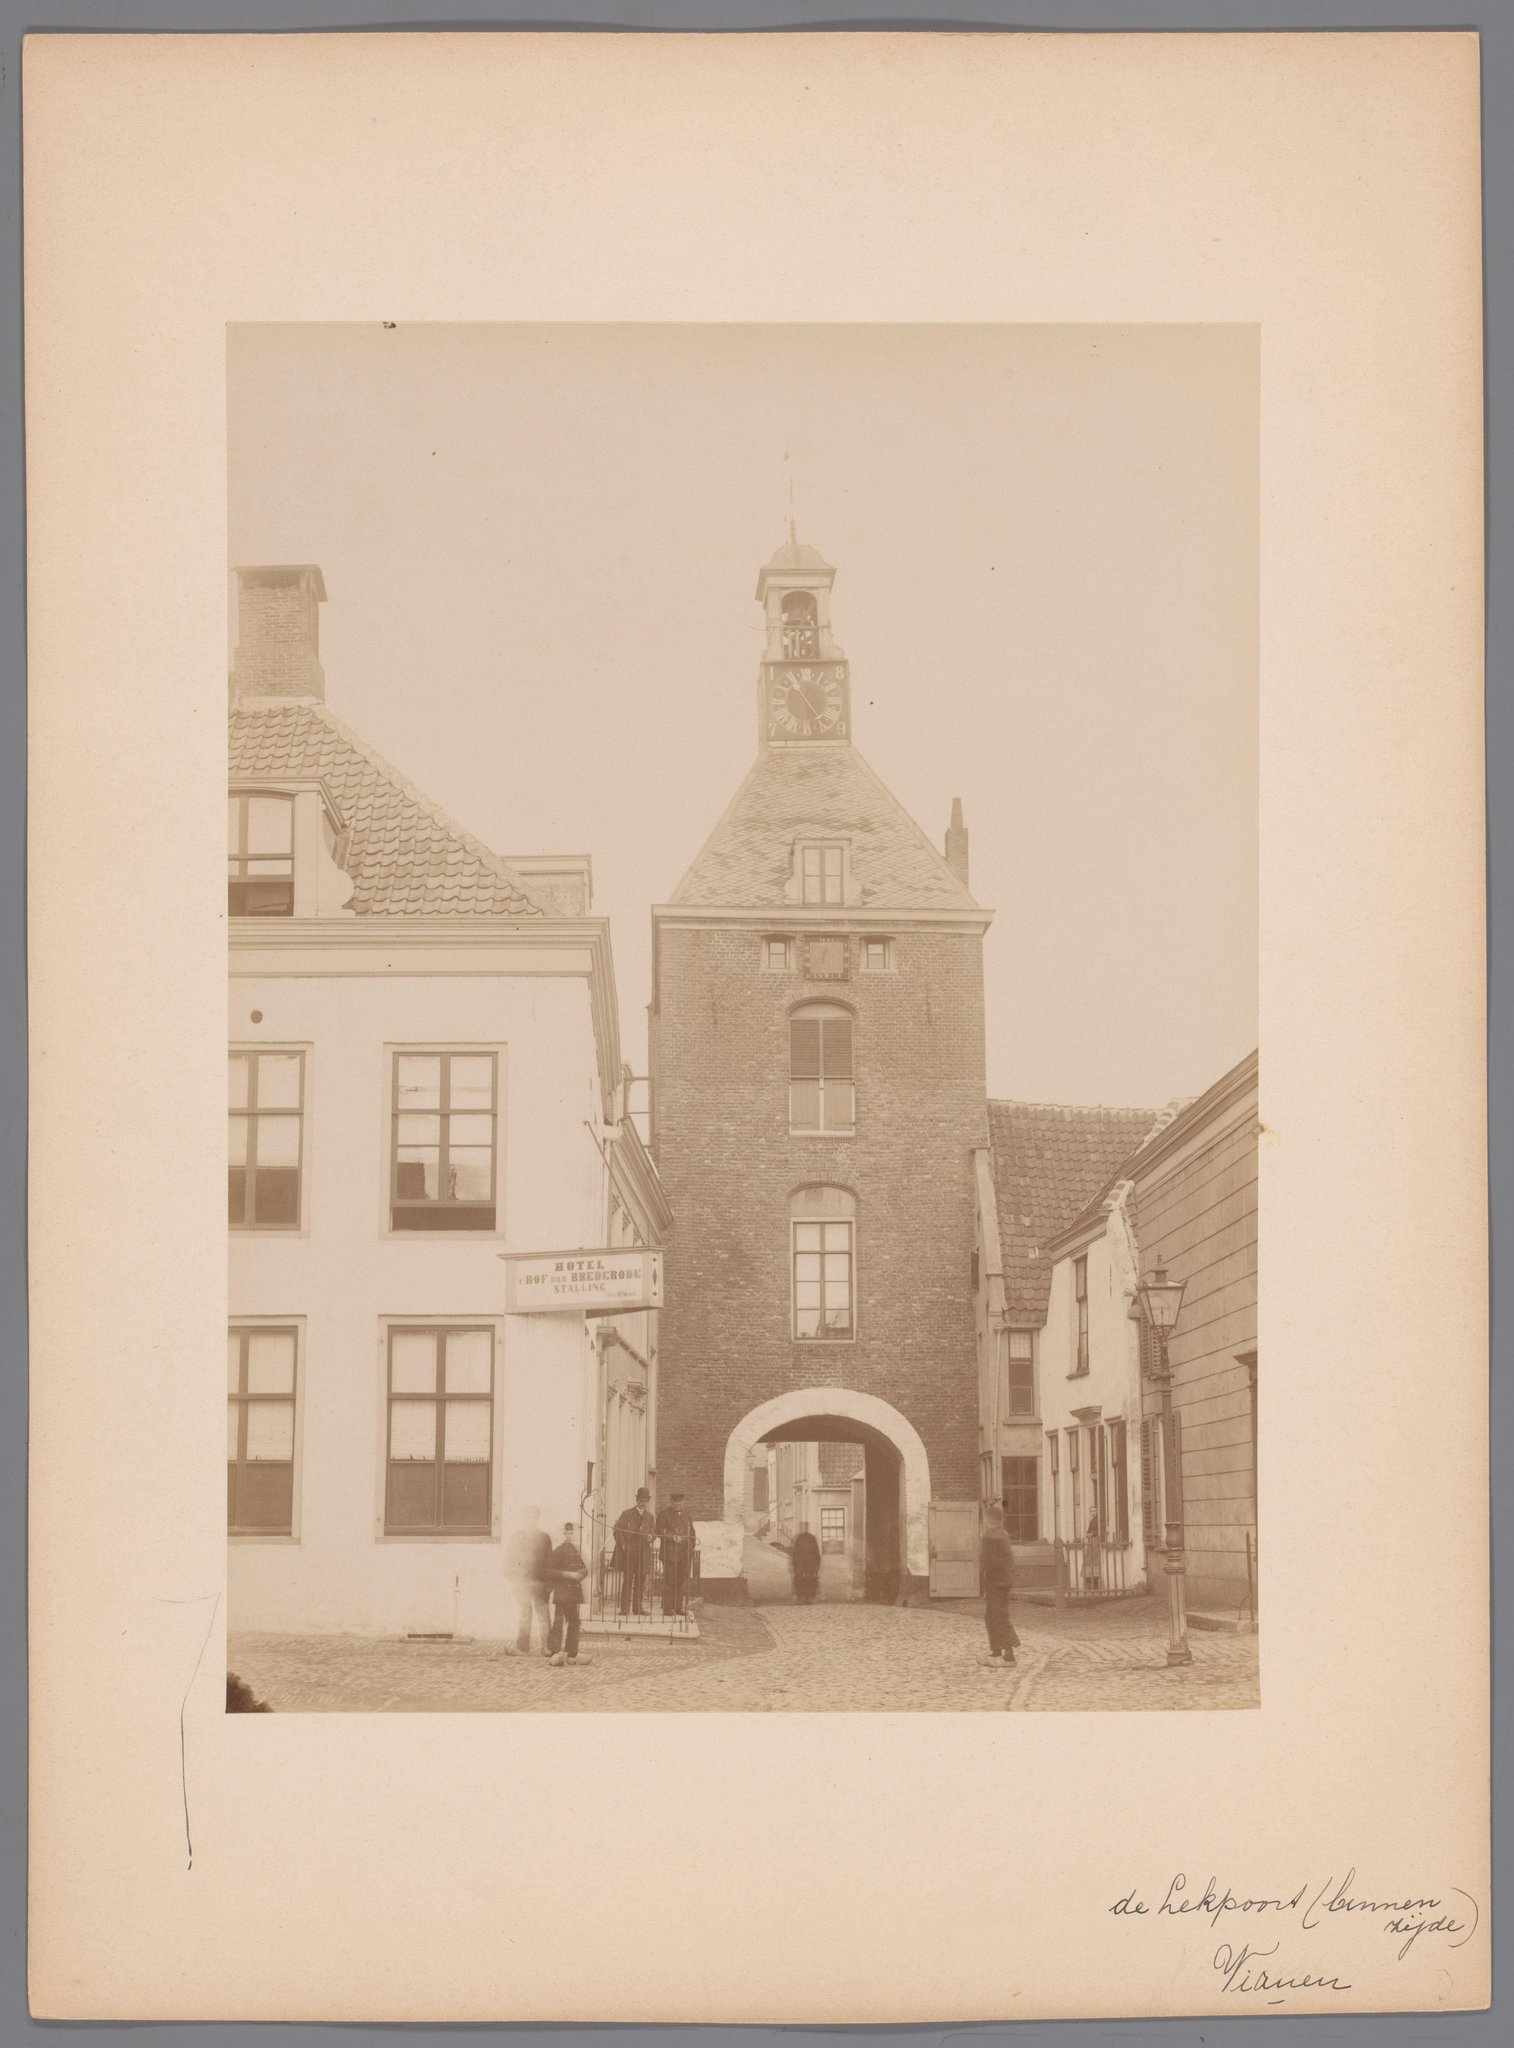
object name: photograph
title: Gezicht op de Lekpoort te Vianen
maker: anoniem (monumentenzorg)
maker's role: fotograaf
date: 1890-1920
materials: cardboard, photographic support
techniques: albumen print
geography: vianen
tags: gate, entrance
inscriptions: annotation: ‘Vianen/ Lekpoort (binnen)’, annotation: ‘de Lekpoort (binnenzijde)/ Vianen’